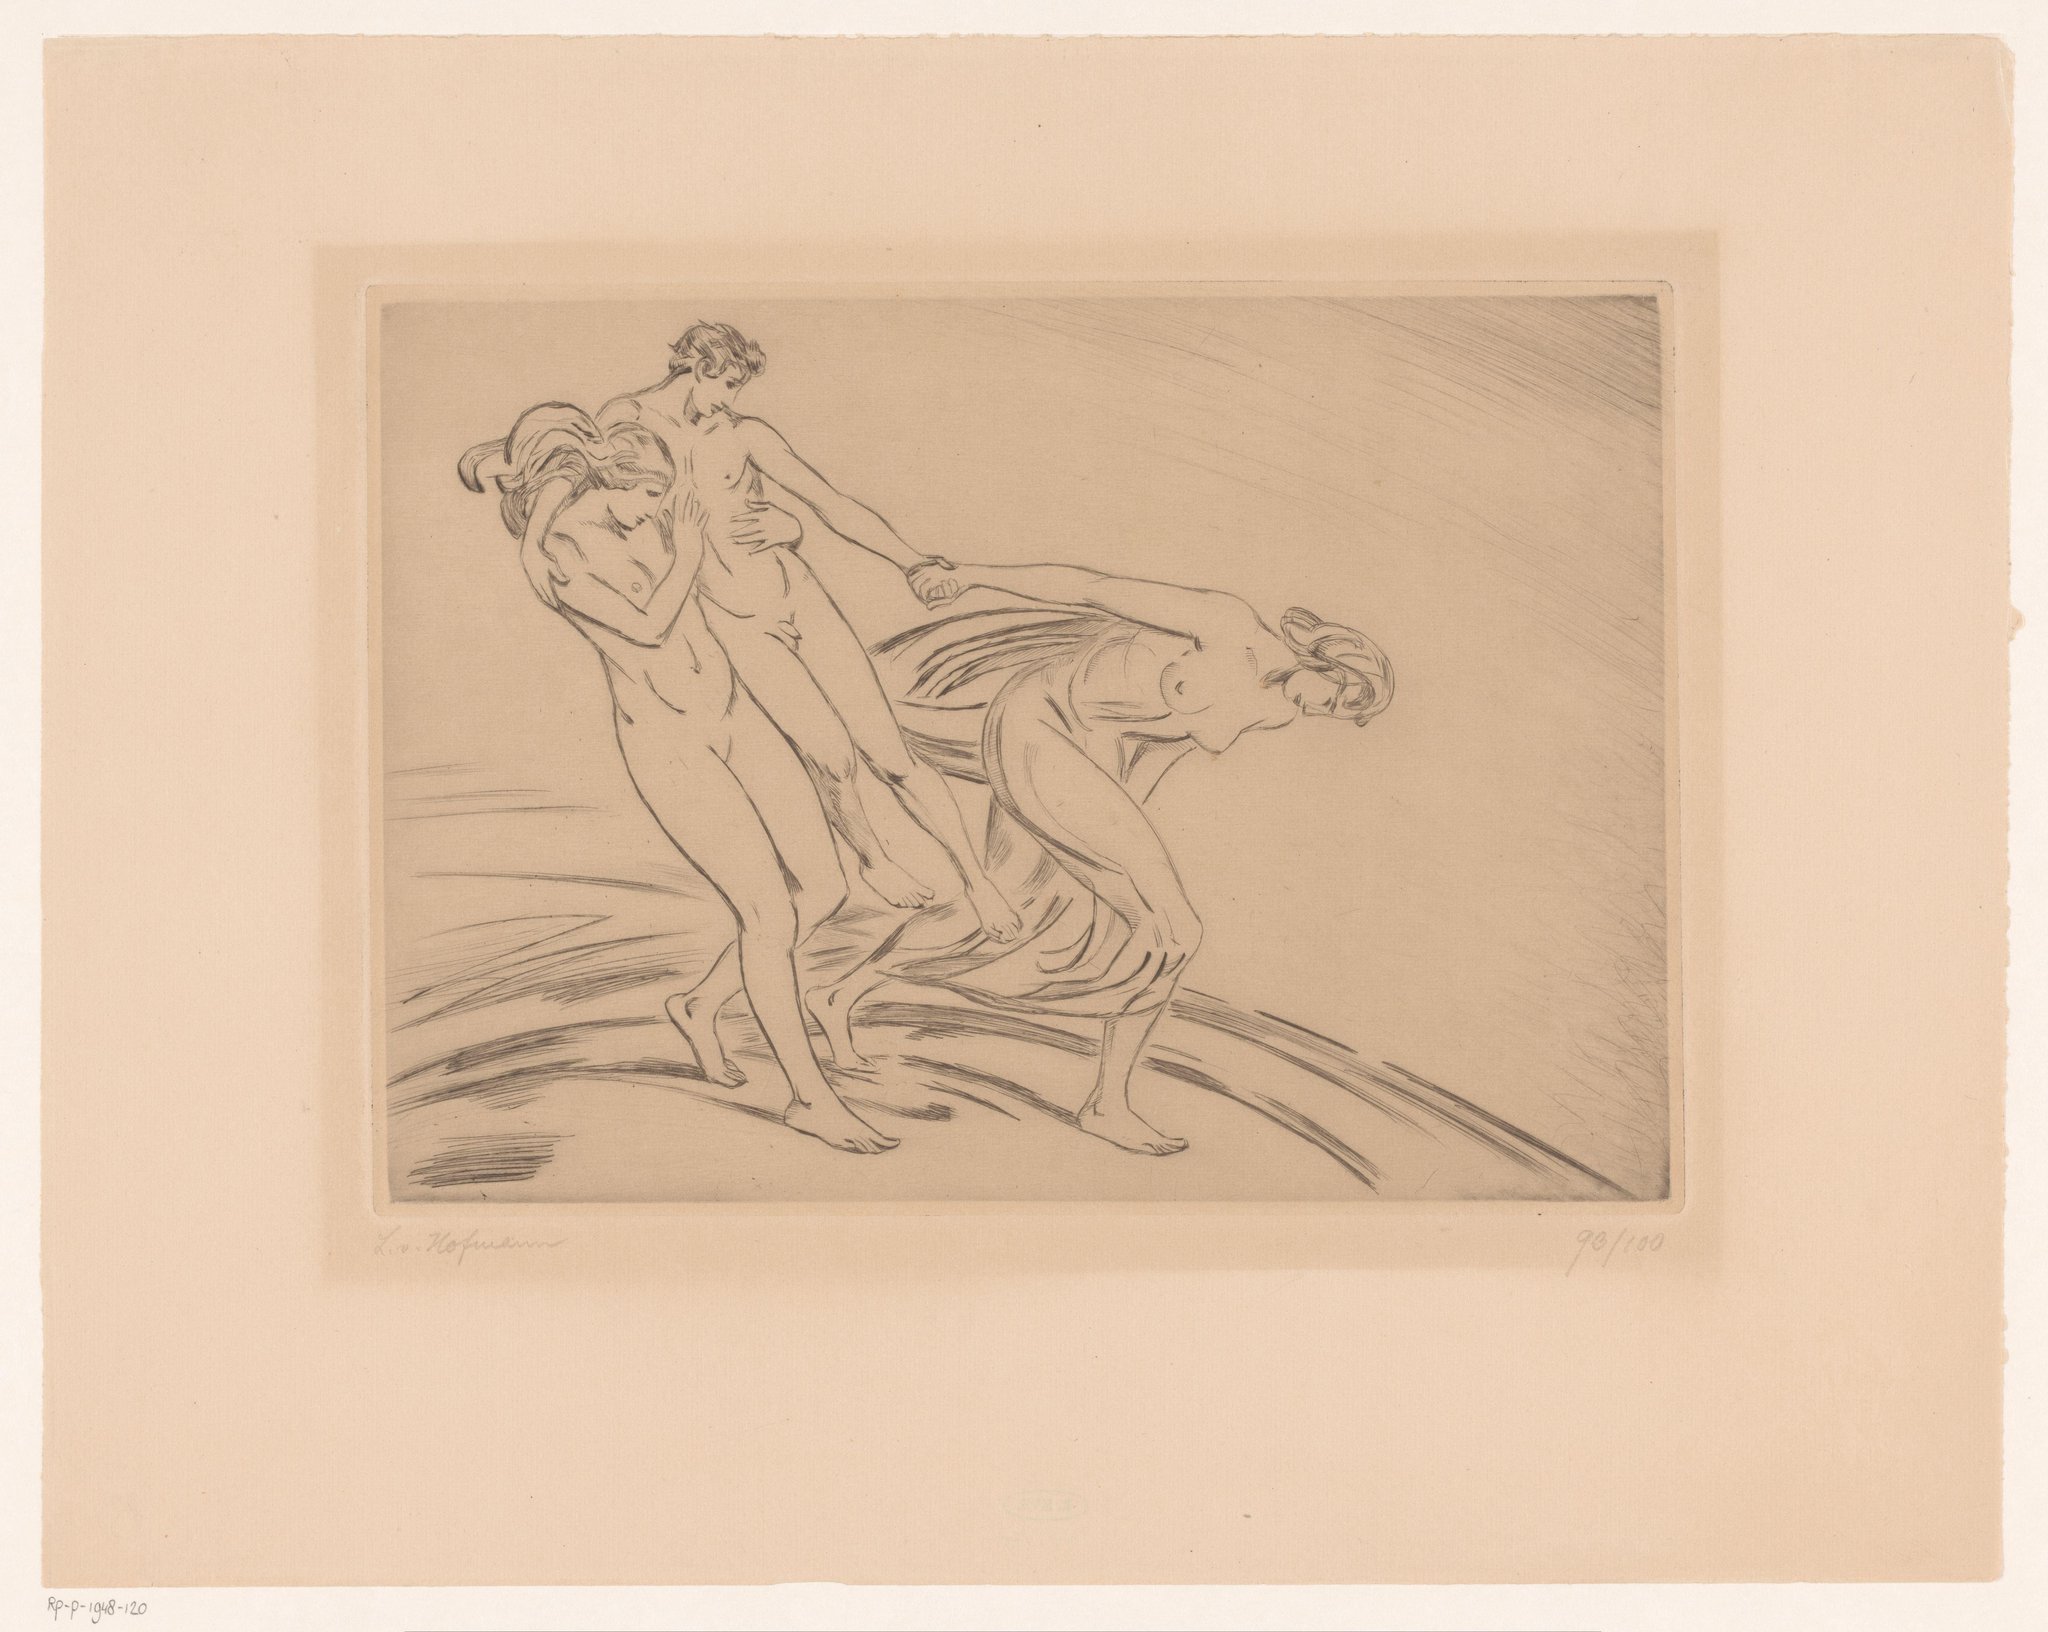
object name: print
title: Twee vrouwen ontvoeren een man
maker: ludwig von hofmann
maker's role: print maker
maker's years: 1861-1945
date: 1871-1945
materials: paper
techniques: drypoint, intaglio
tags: (showing oneself) undressed, quasi-nude, abducting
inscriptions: collector's mark: Lugt 2228